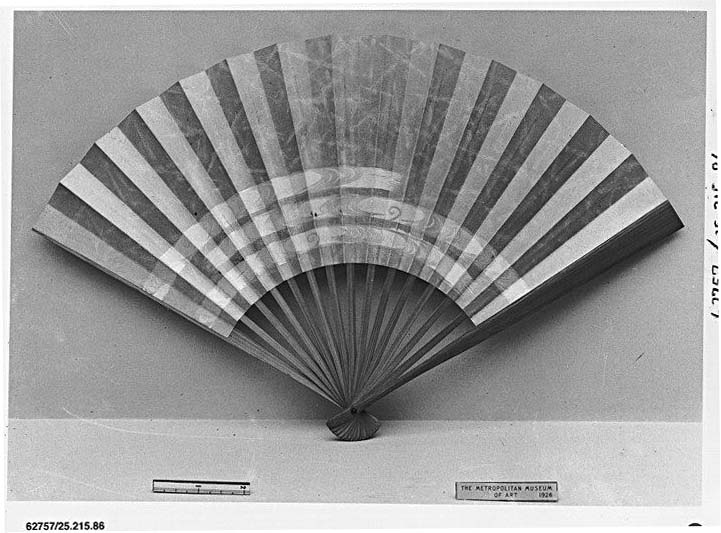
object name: folding fan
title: Fan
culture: japanese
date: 1901-2000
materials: metal, paint, paper